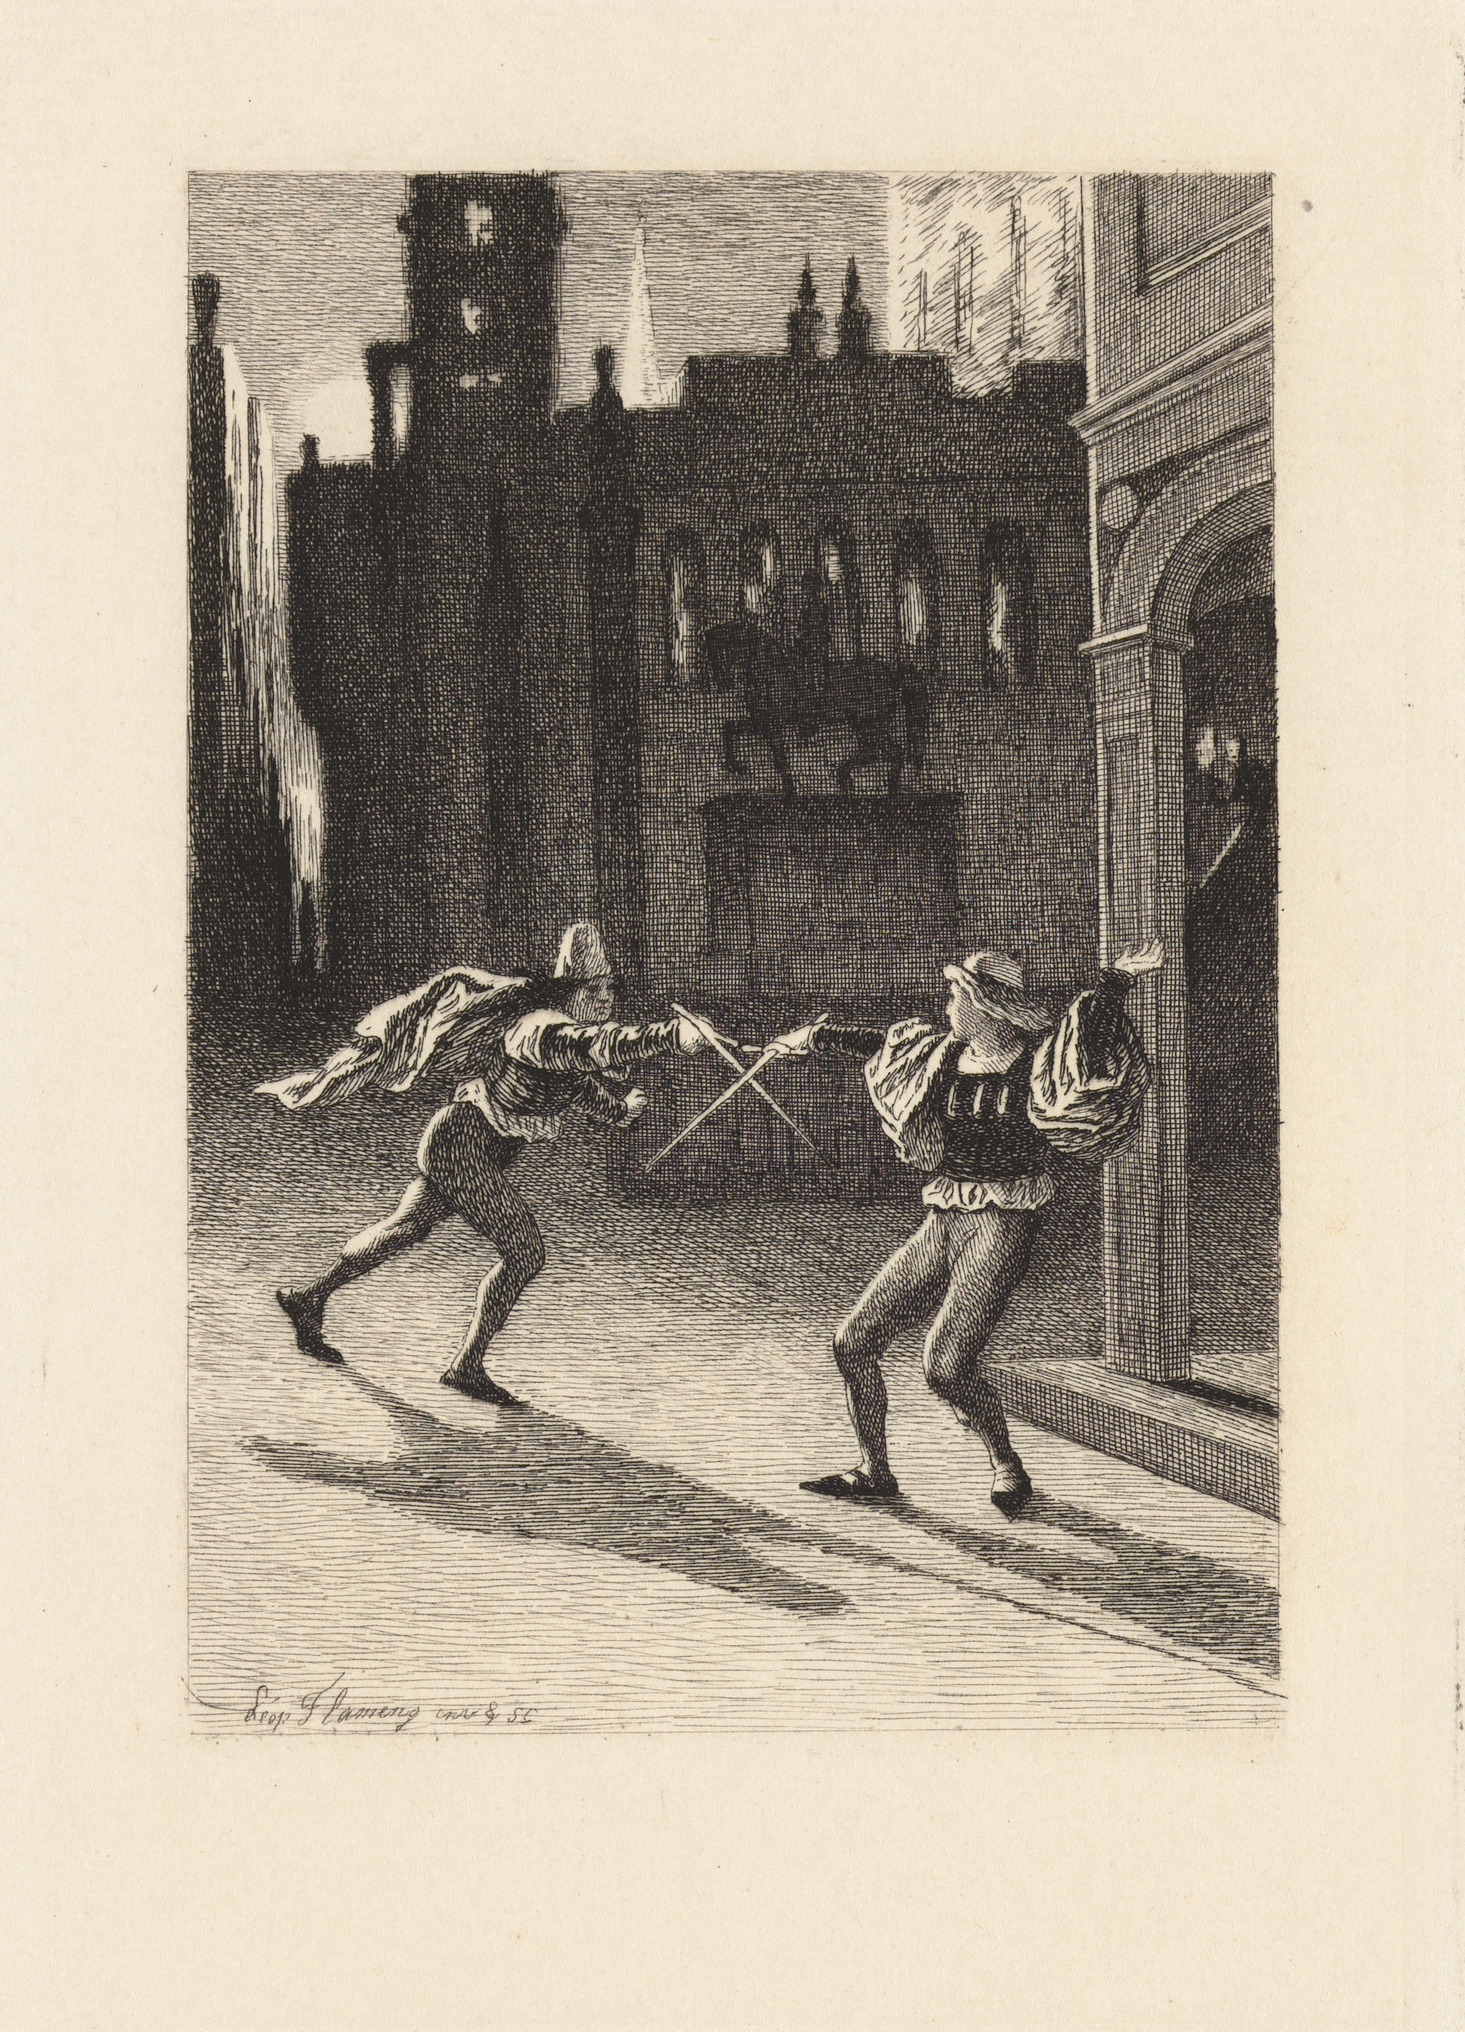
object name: print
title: La Rouerie de Dame Simone, plate 7 from "The Decameron"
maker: léopold flameng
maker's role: engraver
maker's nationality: french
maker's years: 1831-1911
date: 1873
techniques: etching